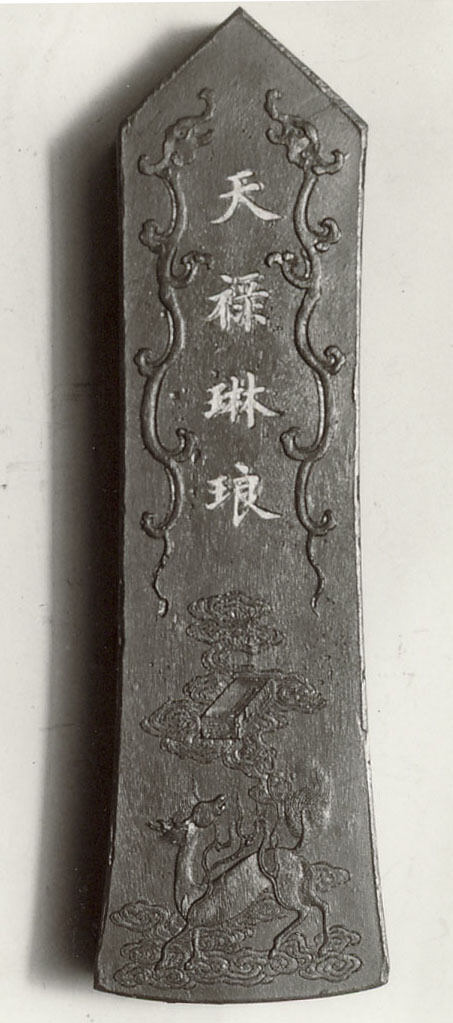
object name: ink tablet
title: Heaven Bestowed Rare Jades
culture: chinese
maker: jian guzhai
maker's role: artist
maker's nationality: chinese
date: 1867-1933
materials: ink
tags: deer